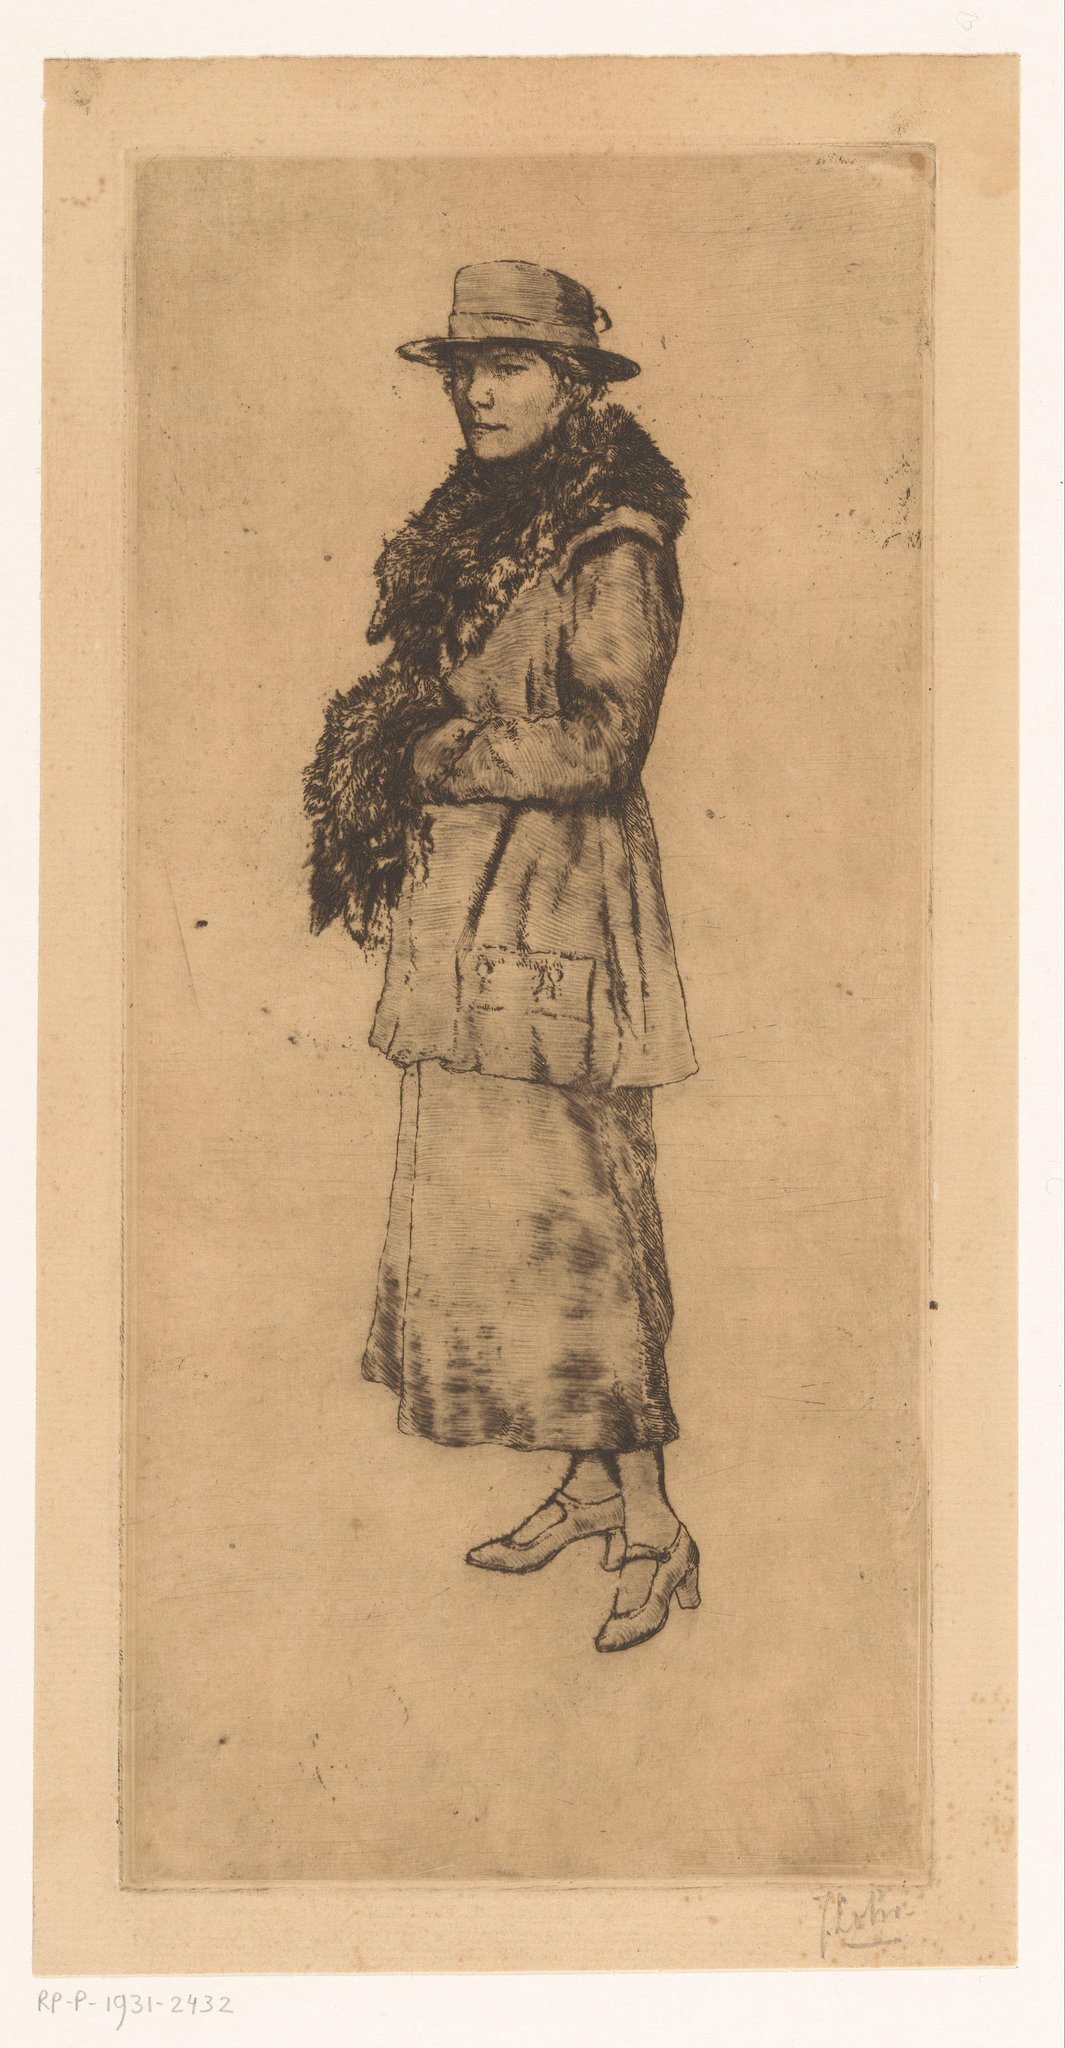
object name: print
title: Jonge vrouw met mof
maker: johannes löhr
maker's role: print maker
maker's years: 1882-1928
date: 1892-1928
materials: paper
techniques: etching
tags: adolescent, young woman, maiden, muff, neck-gear ~ clothing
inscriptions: collector's mark: Lugt 2228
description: Mogelijk betreft het een portret van de vrouw van de kunstenaar, Clara Löhr.